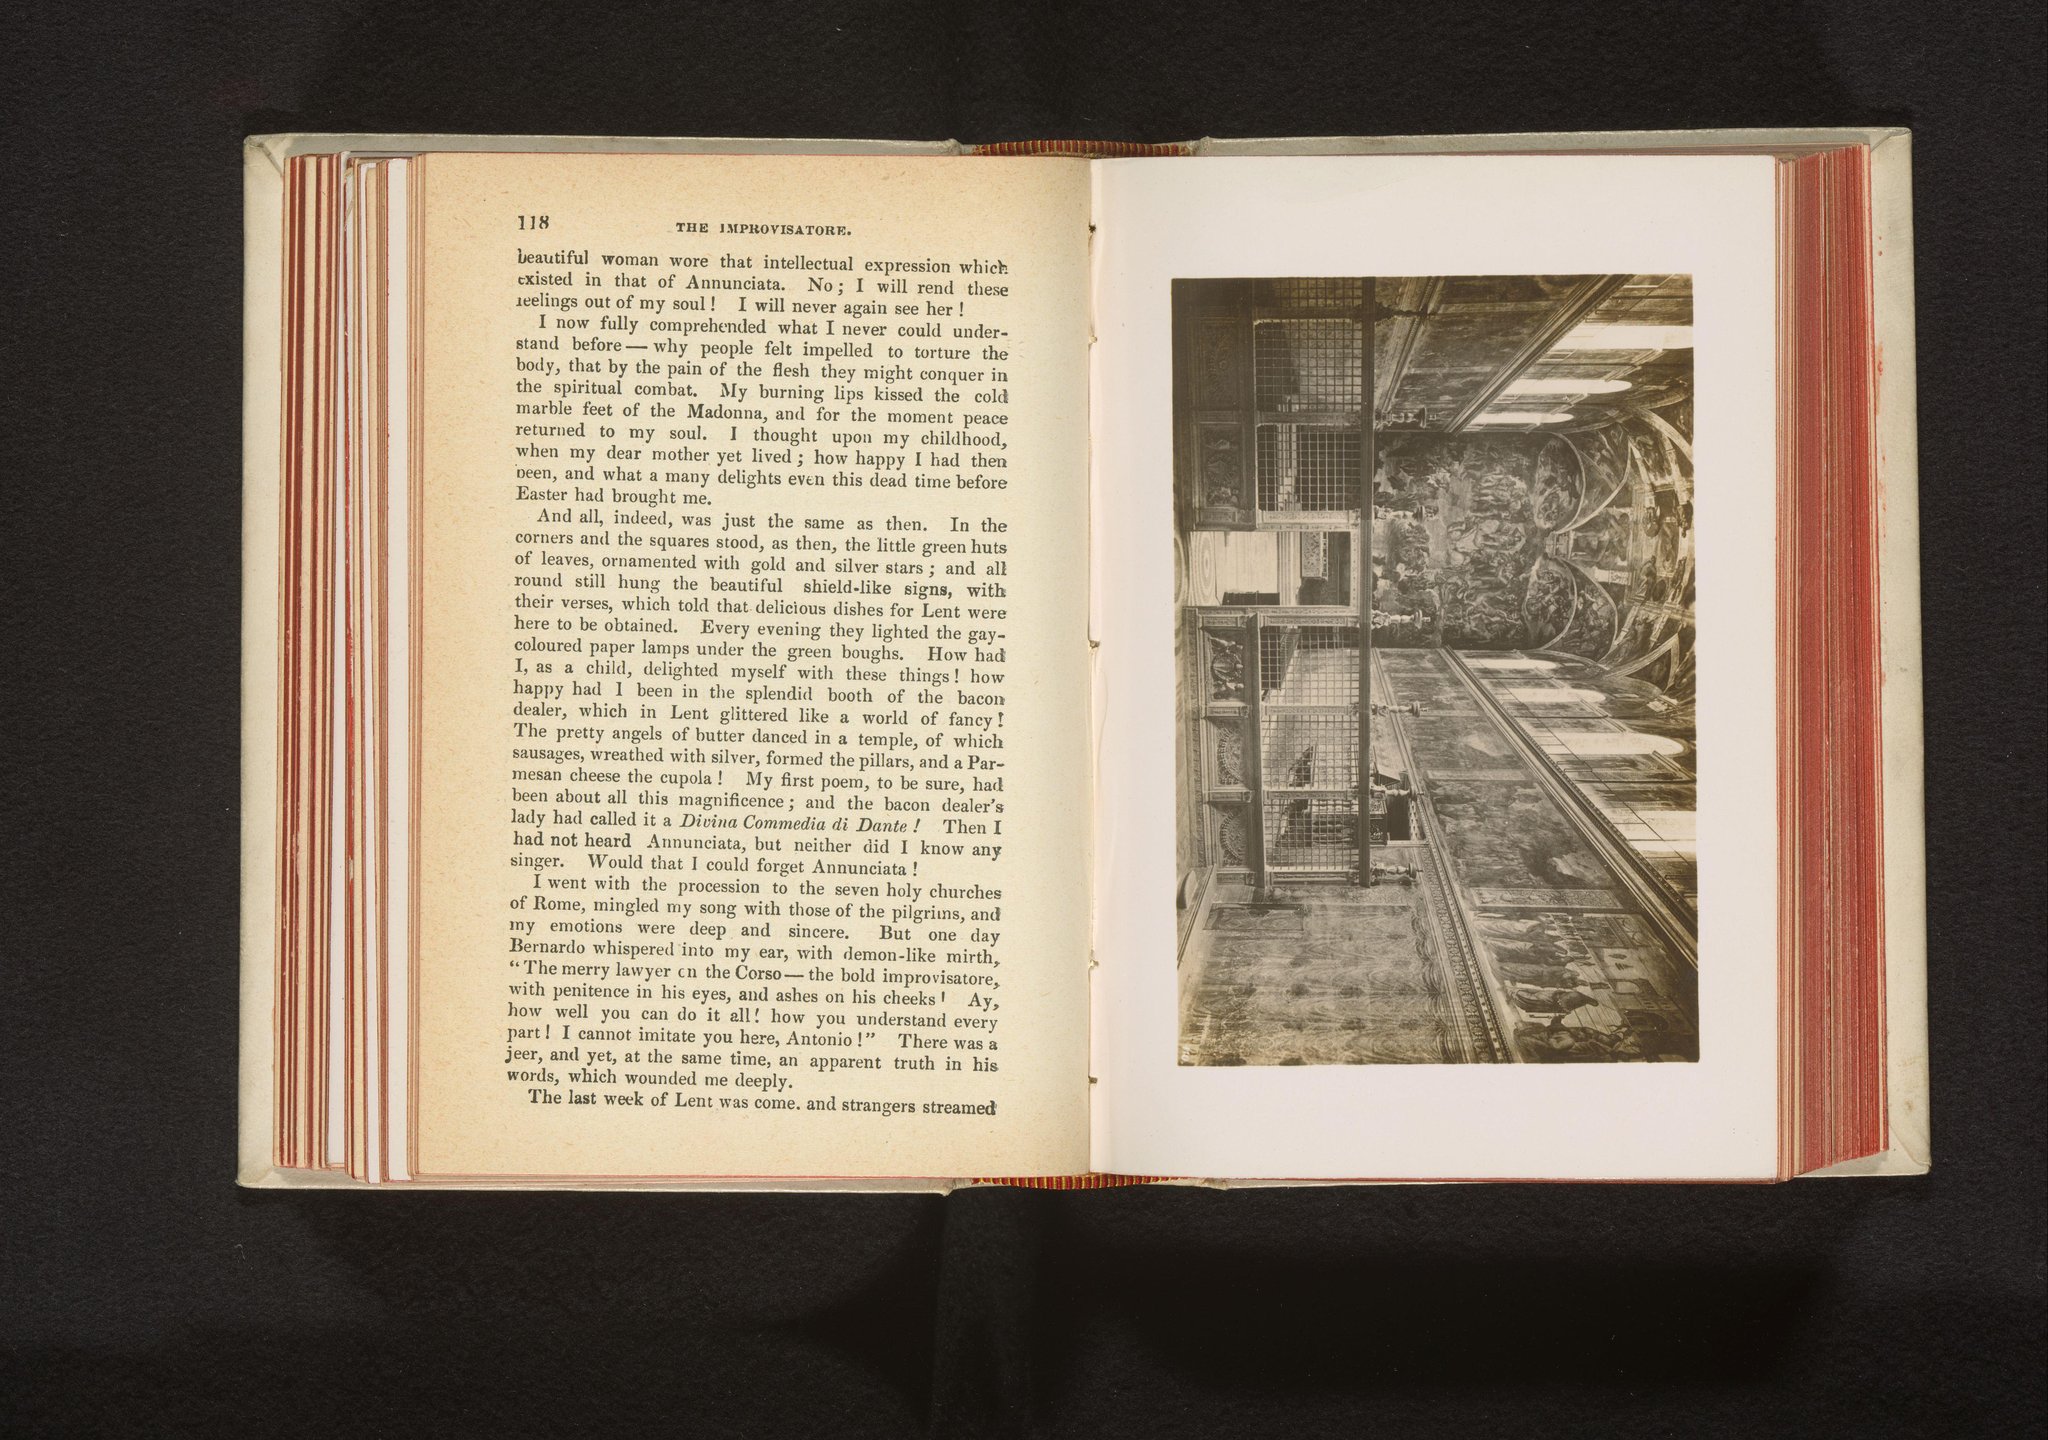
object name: photograph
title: Interieur van de Sixtijnse Kapel te Vaticaanstad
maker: Anonymous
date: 1870-1880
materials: photographic support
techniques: gelatin silver print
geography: vatican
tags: interior ~ representation of a building, parts of church interior: chapel